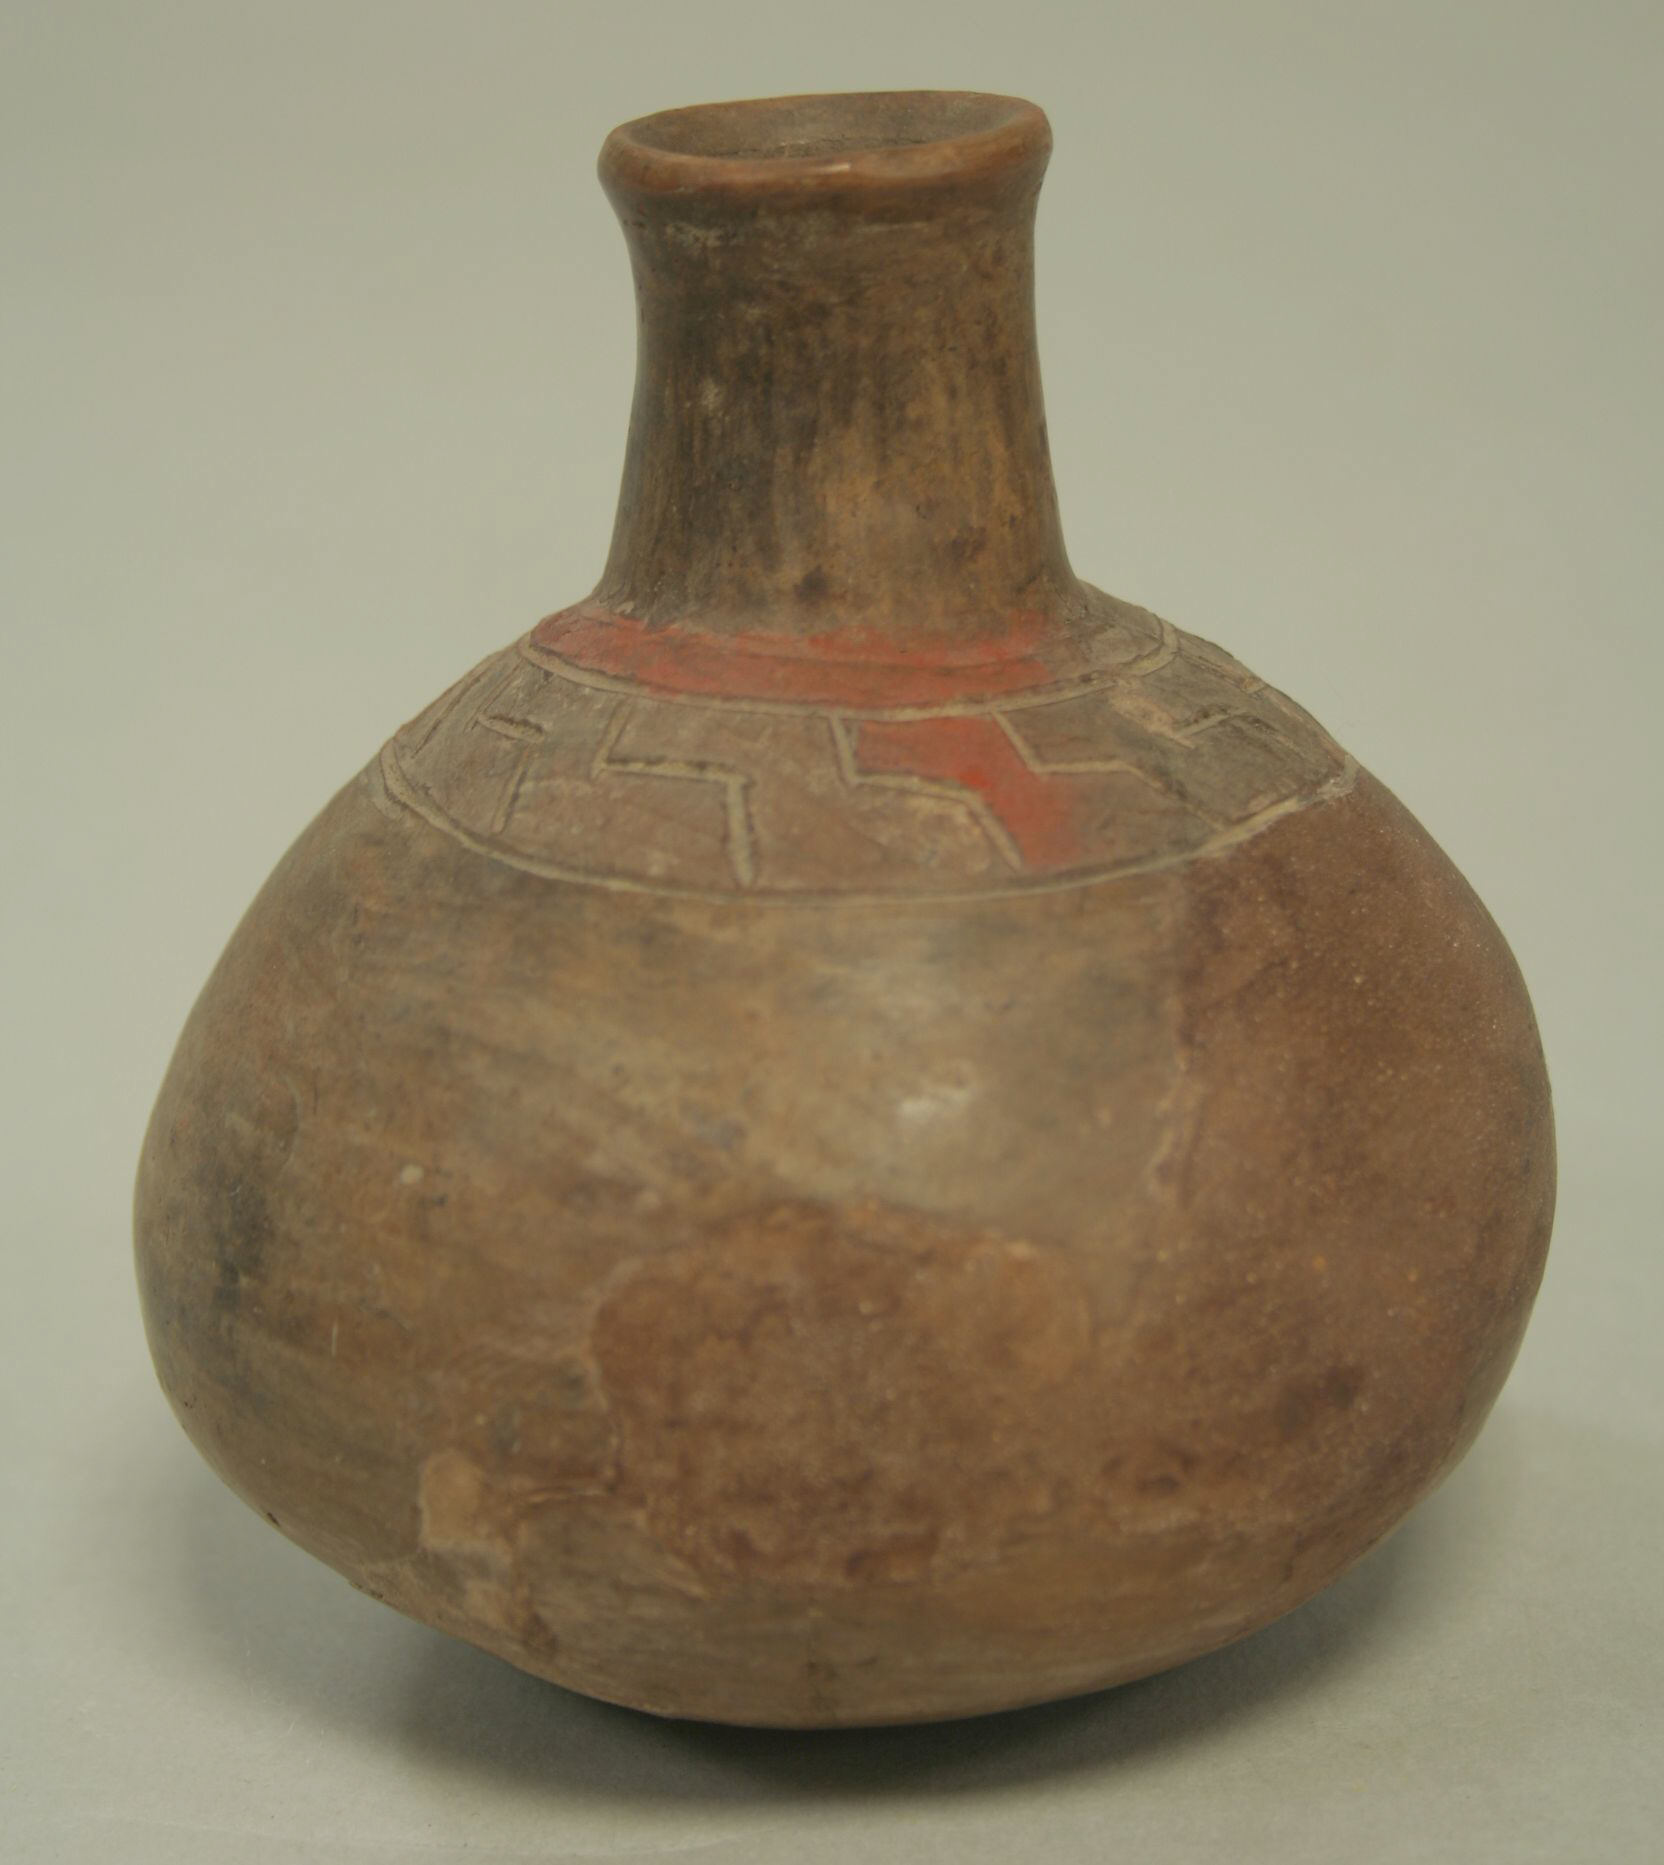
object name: bottle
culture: paracas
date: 600-301 BCE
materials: ceramic, pigment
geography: peru